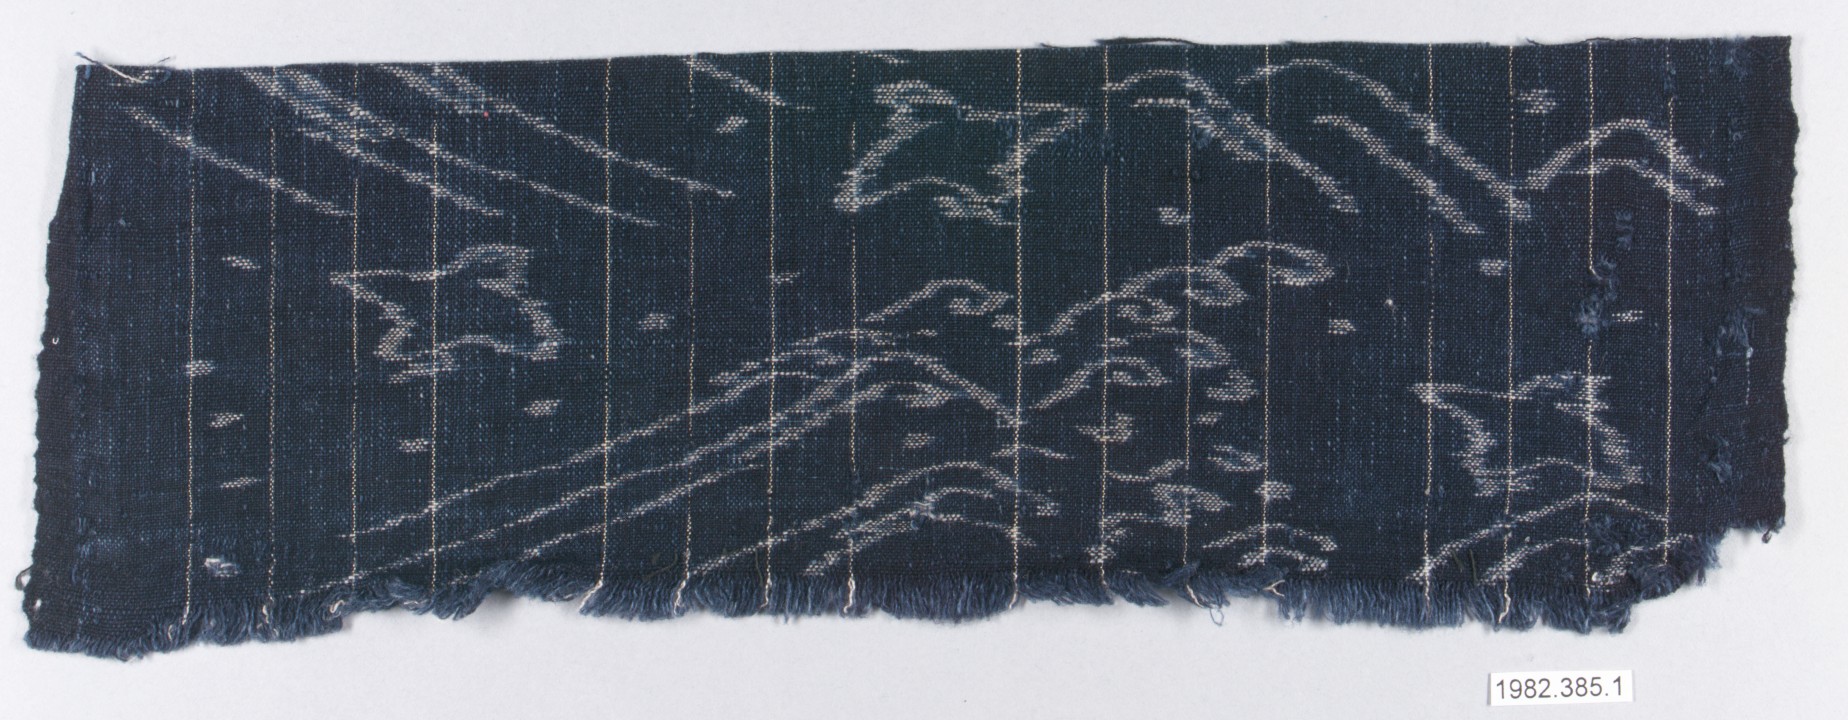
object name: piece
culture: japanese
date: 1868-1926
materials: cotton, fiber, silk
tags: birds